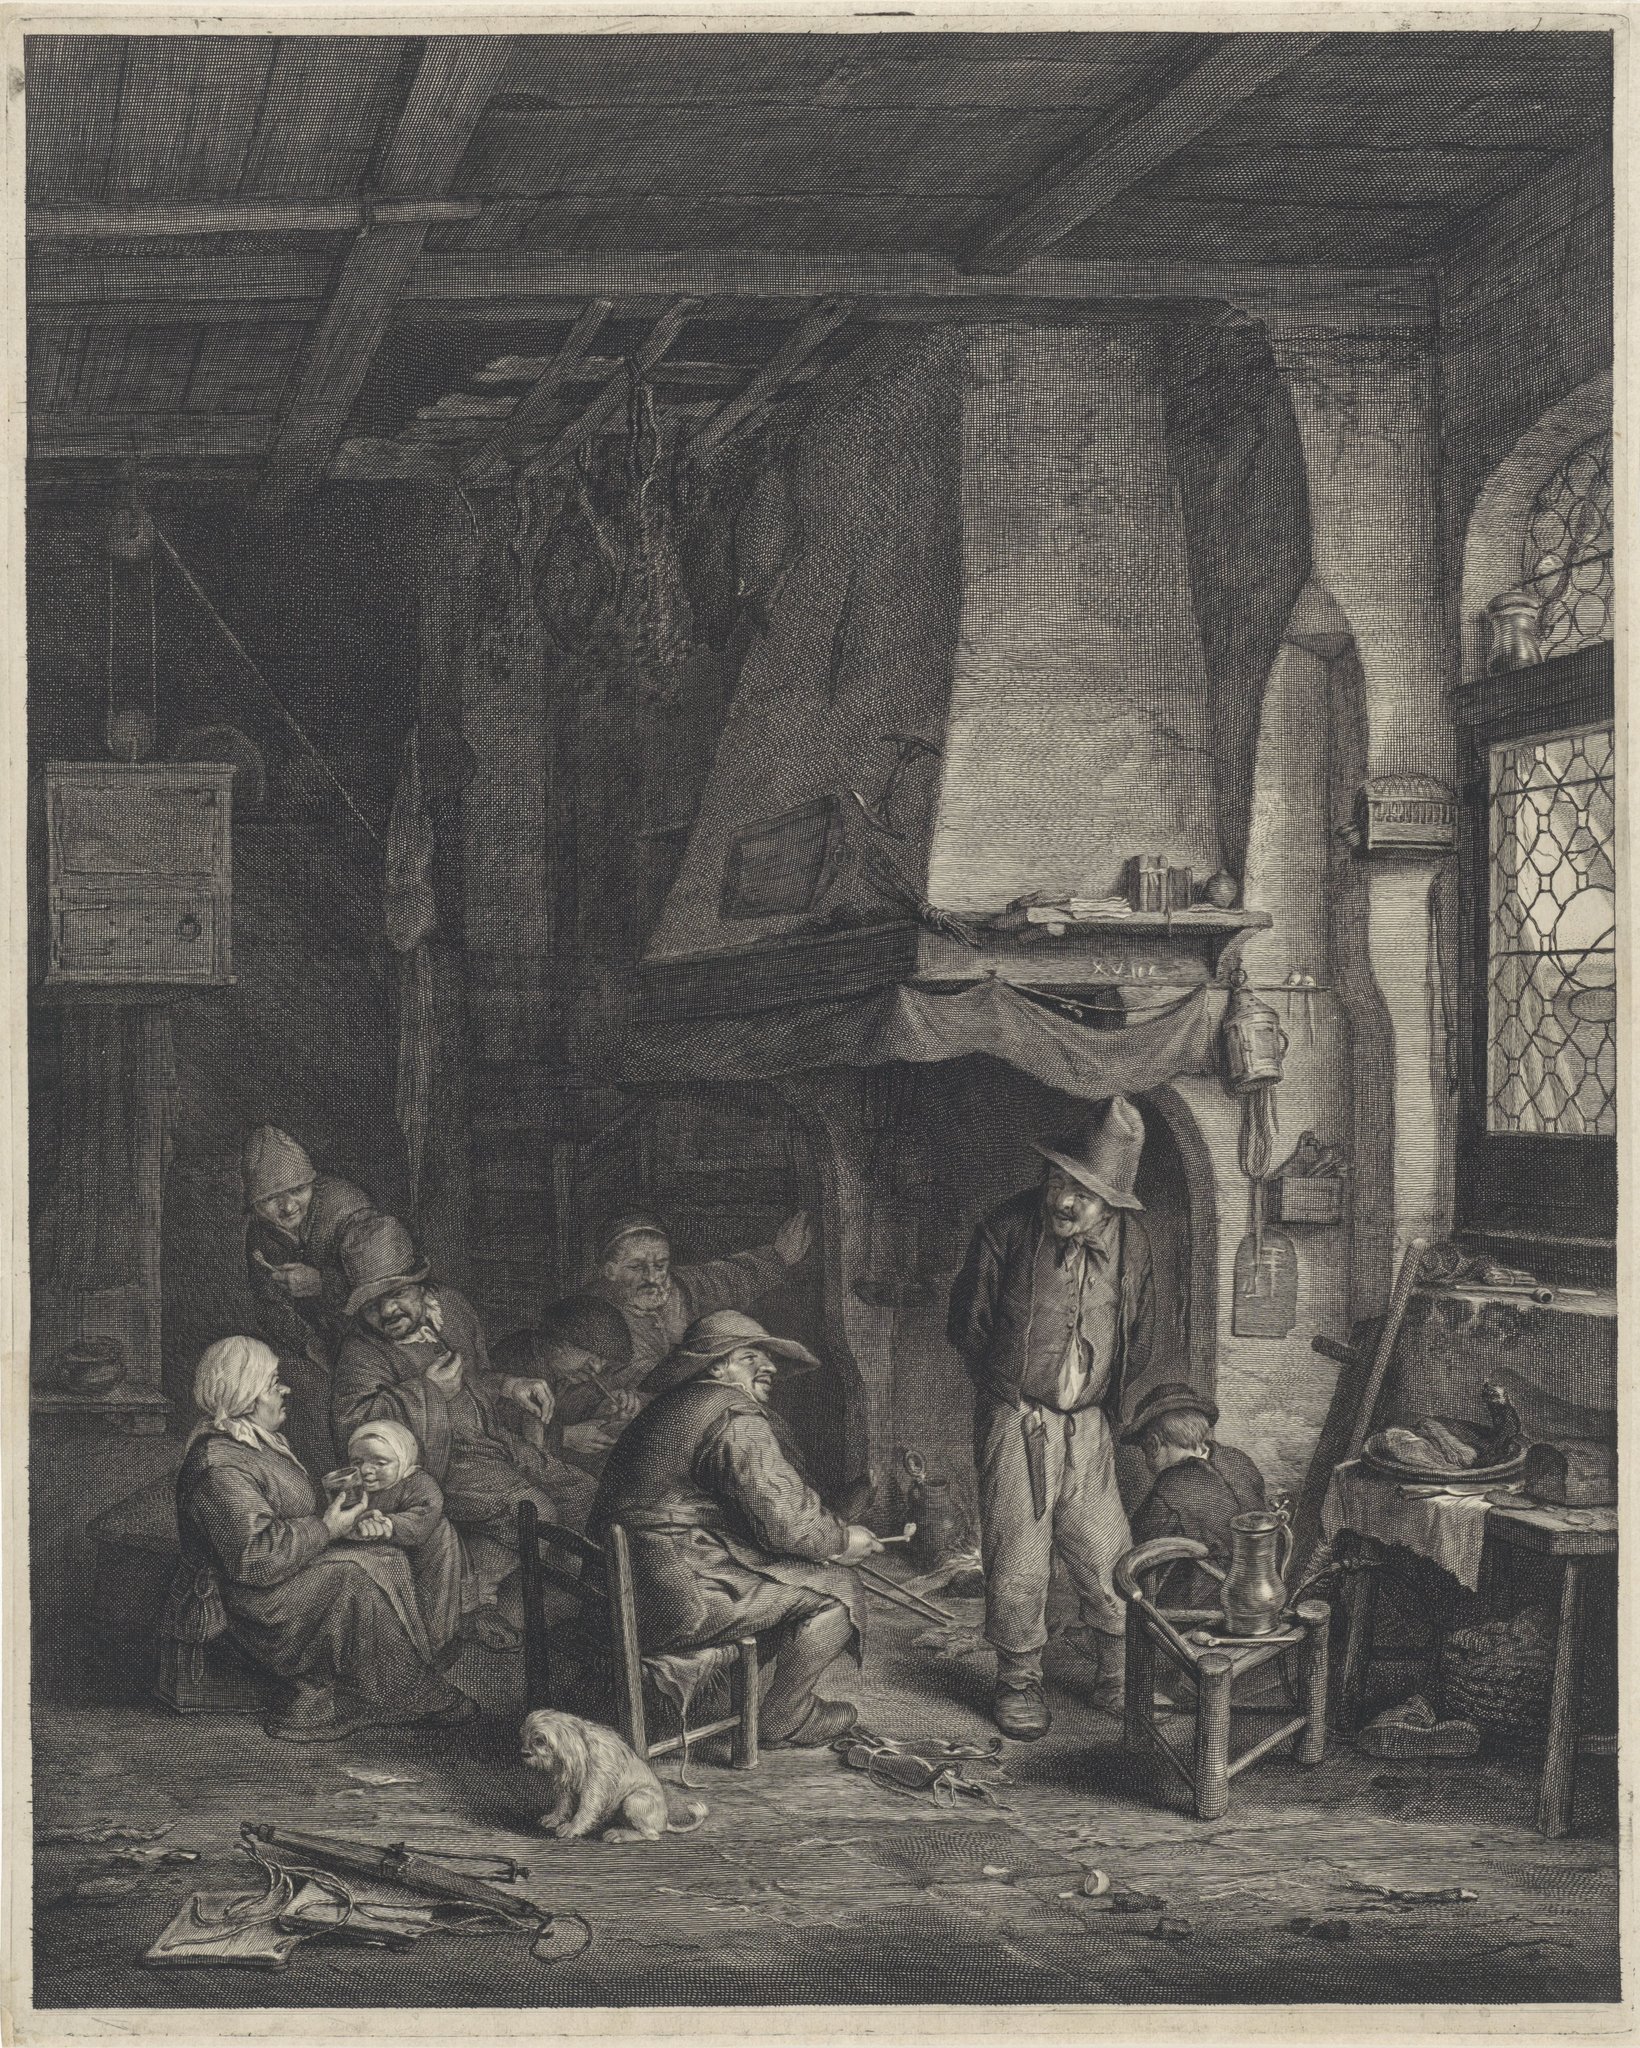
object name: print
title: Herberginterieur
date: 1638-1658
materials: paper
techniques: engraving, etching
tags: inn, coffee-house, public house, etc., pipe ~ tobacco, open hearth, fire-place, skates (winter sports), conversation, dialogue; conversation piece, dog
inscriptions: collector's mark: Lugt 240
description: In een herberg warmt een groep mensen zich bij de haard. Ze roken hun pijp, drinken bier en maken een praatje met elkaar. Op de grond liggen schaatsen en gebroken eierschalen. Voor de haard hangen stukken vlees.